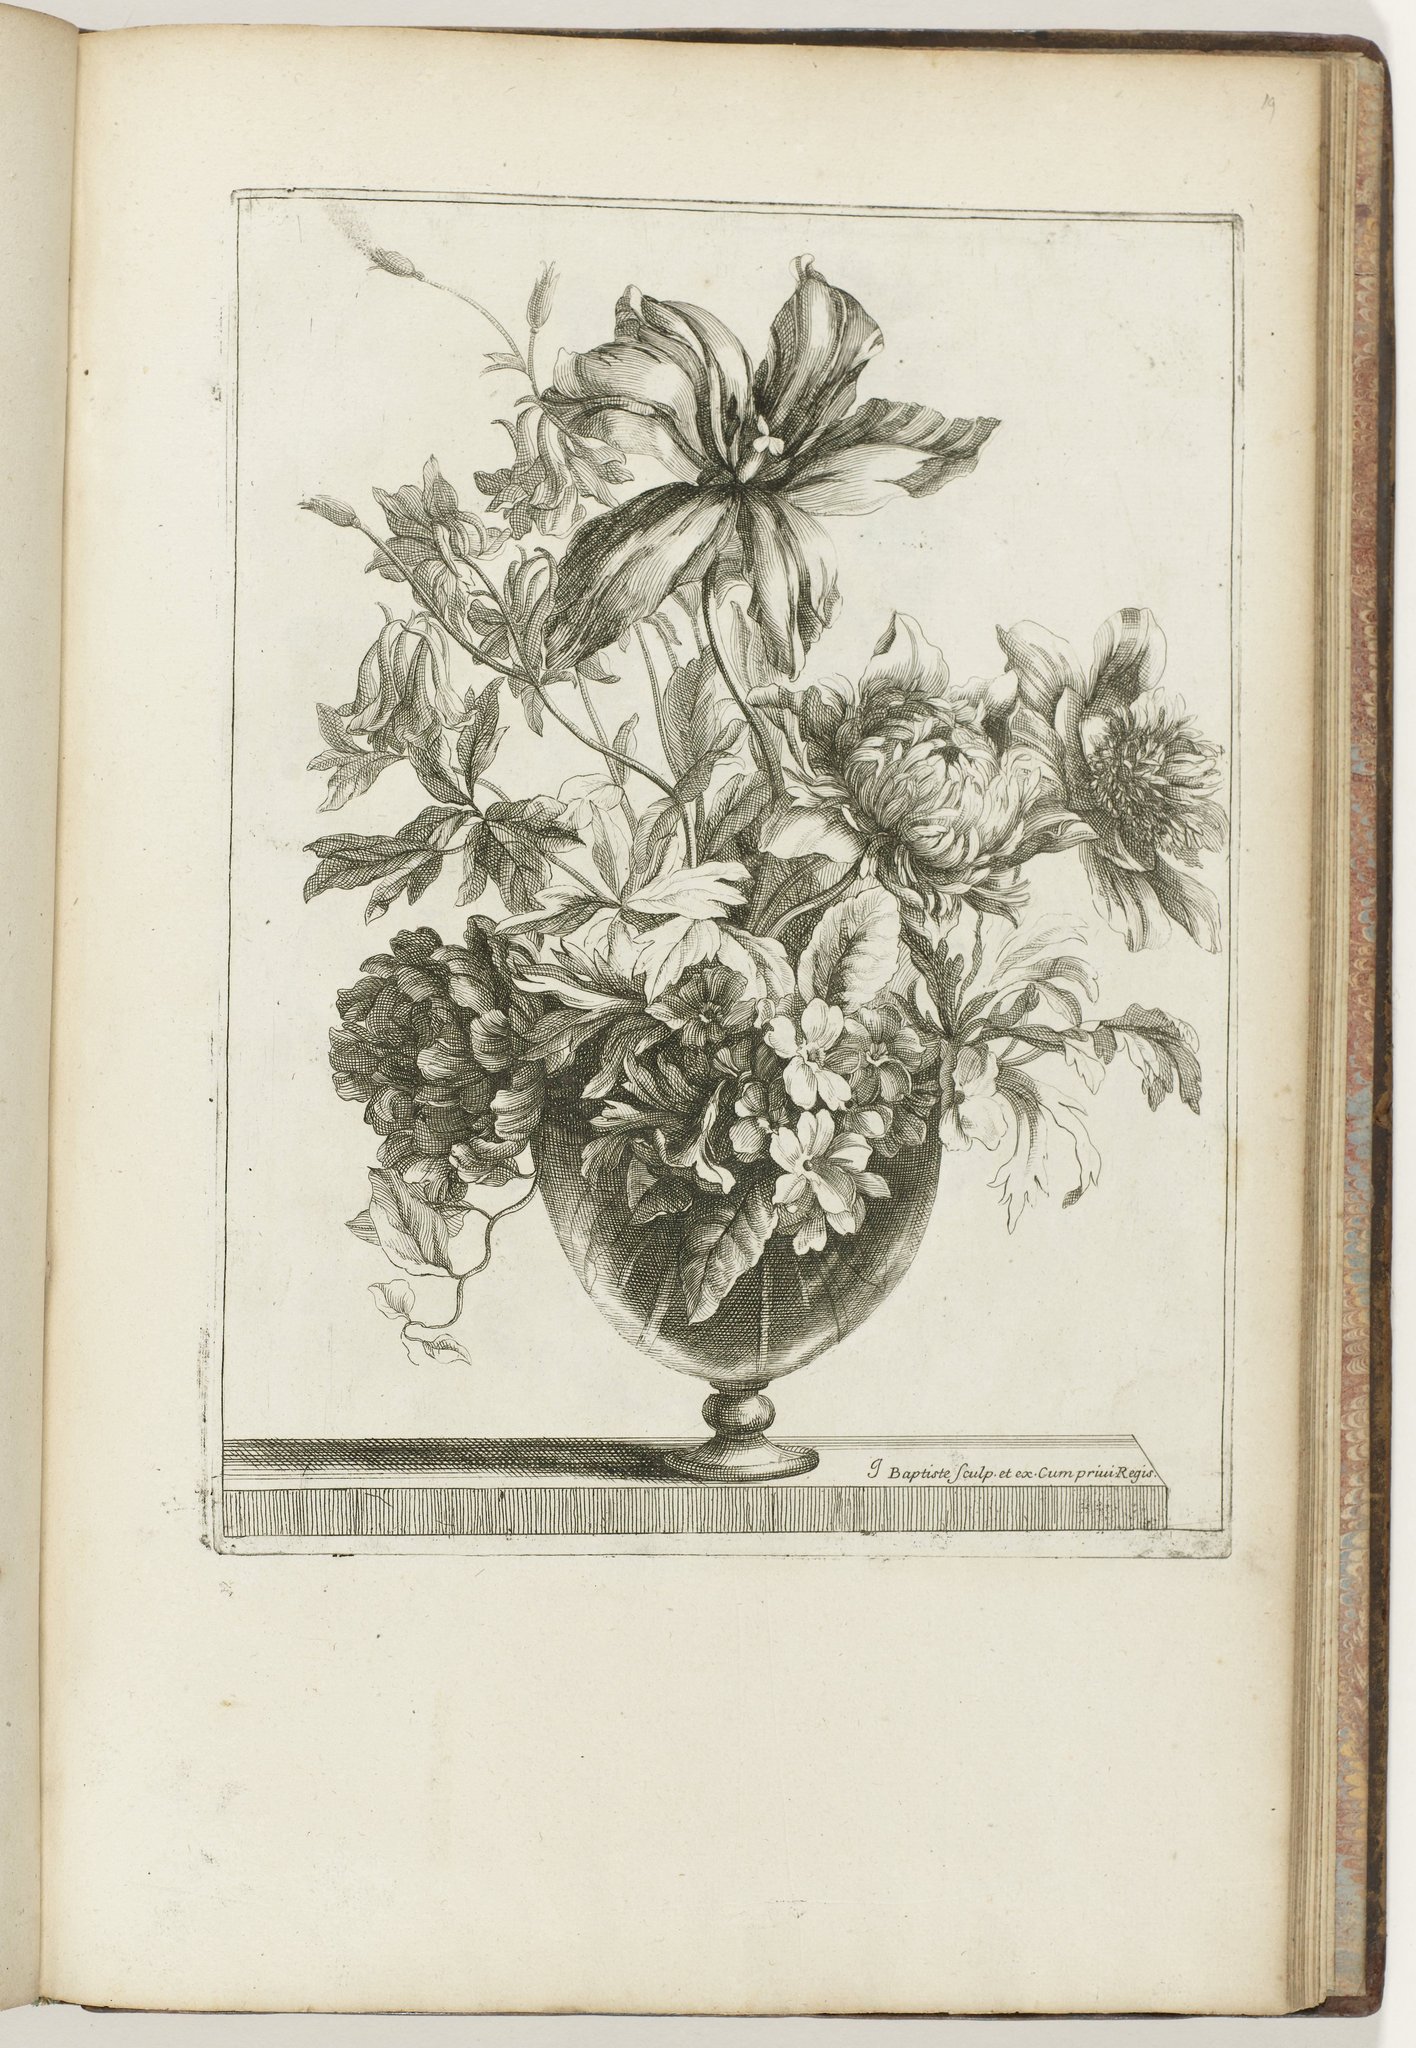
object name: print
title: Boeket in glazen vaas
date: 1680-1695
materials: paper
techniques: etching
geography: paris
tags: flowers in a vase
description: Boeket in glazen vaas. Prent maakt deel uit van een album.